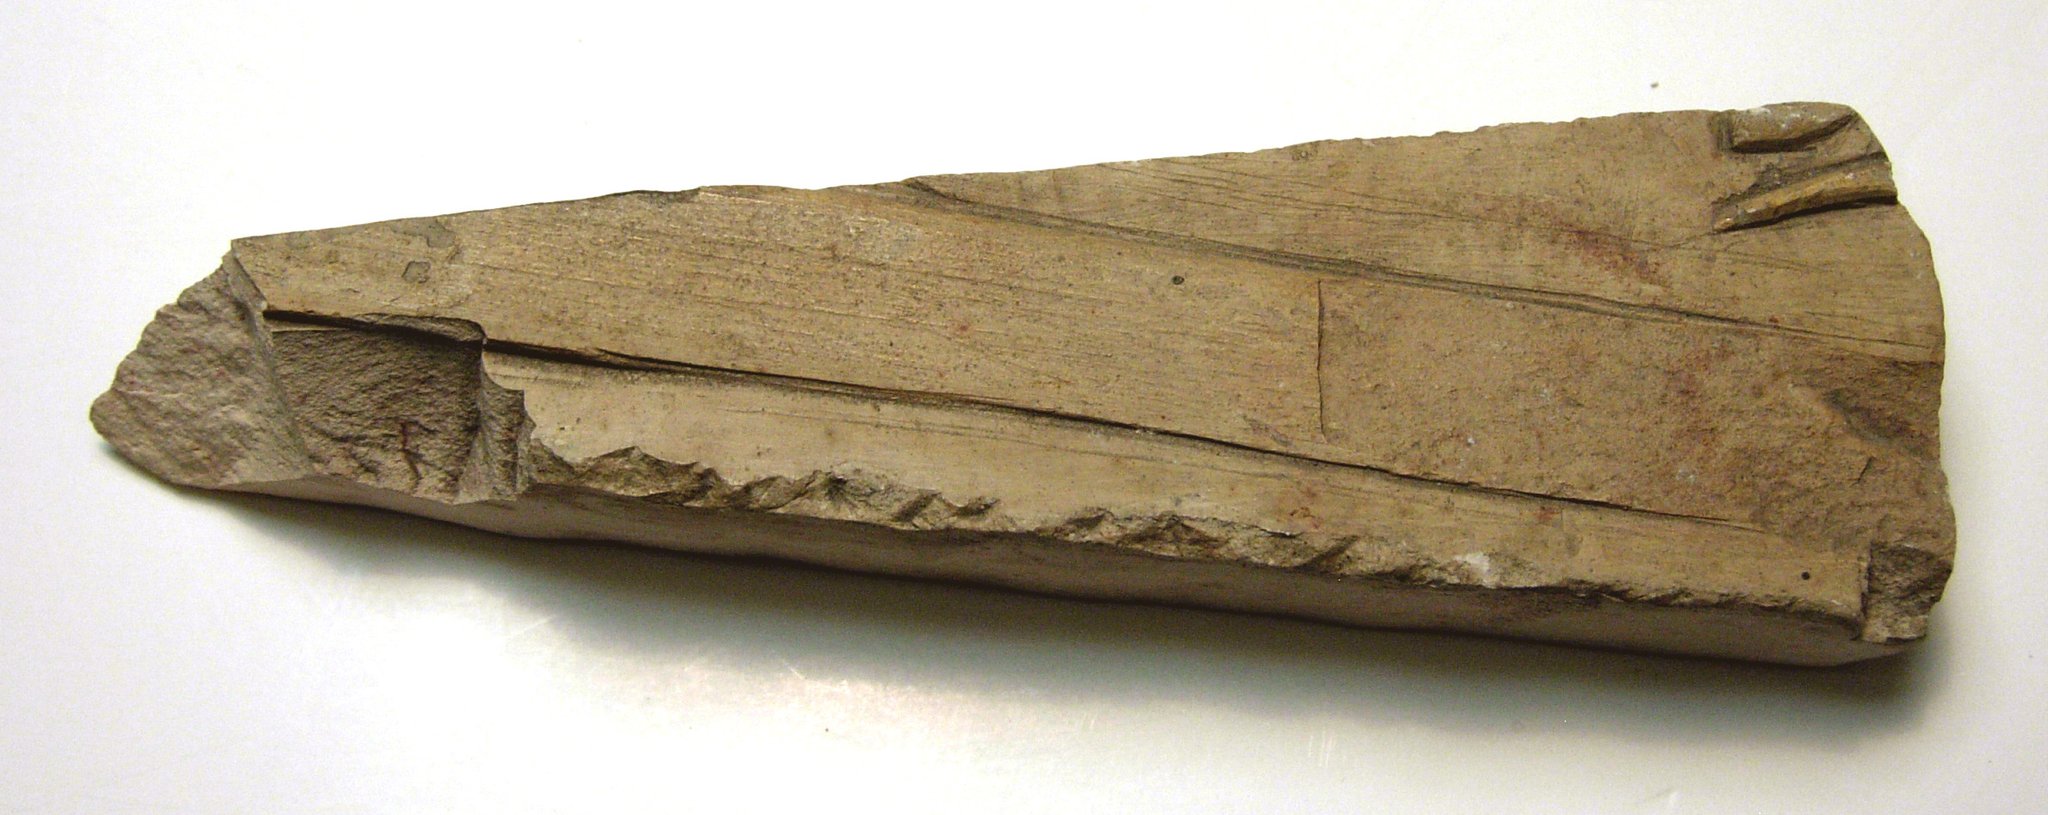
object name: relief, tomb of nespekashuty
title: Raised relief fragment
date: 664-610 BCE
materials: limestone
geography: egypt